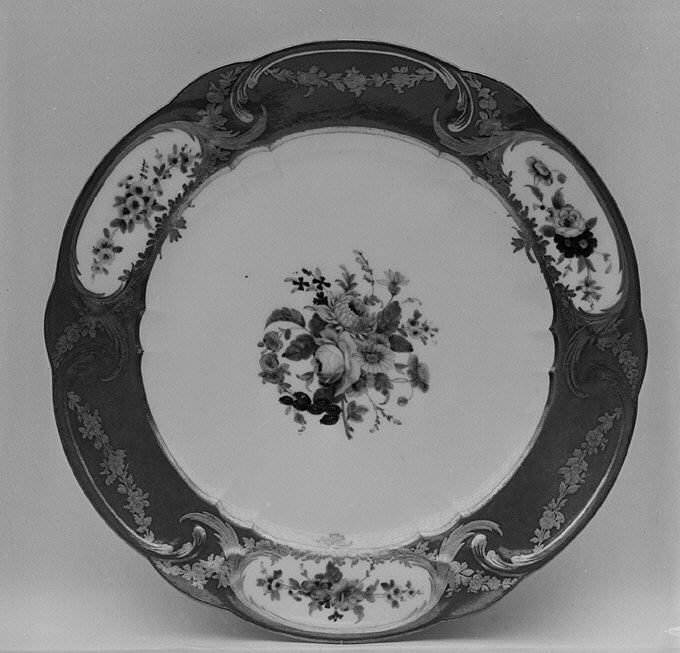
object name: plate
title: Plate (Assiette à palmes) (1 of 102) (part of a service)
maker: sèvres manufactory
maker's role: manufactory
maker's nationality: french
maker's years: 1740-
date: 1780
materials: soft paste porcelain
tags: flowers